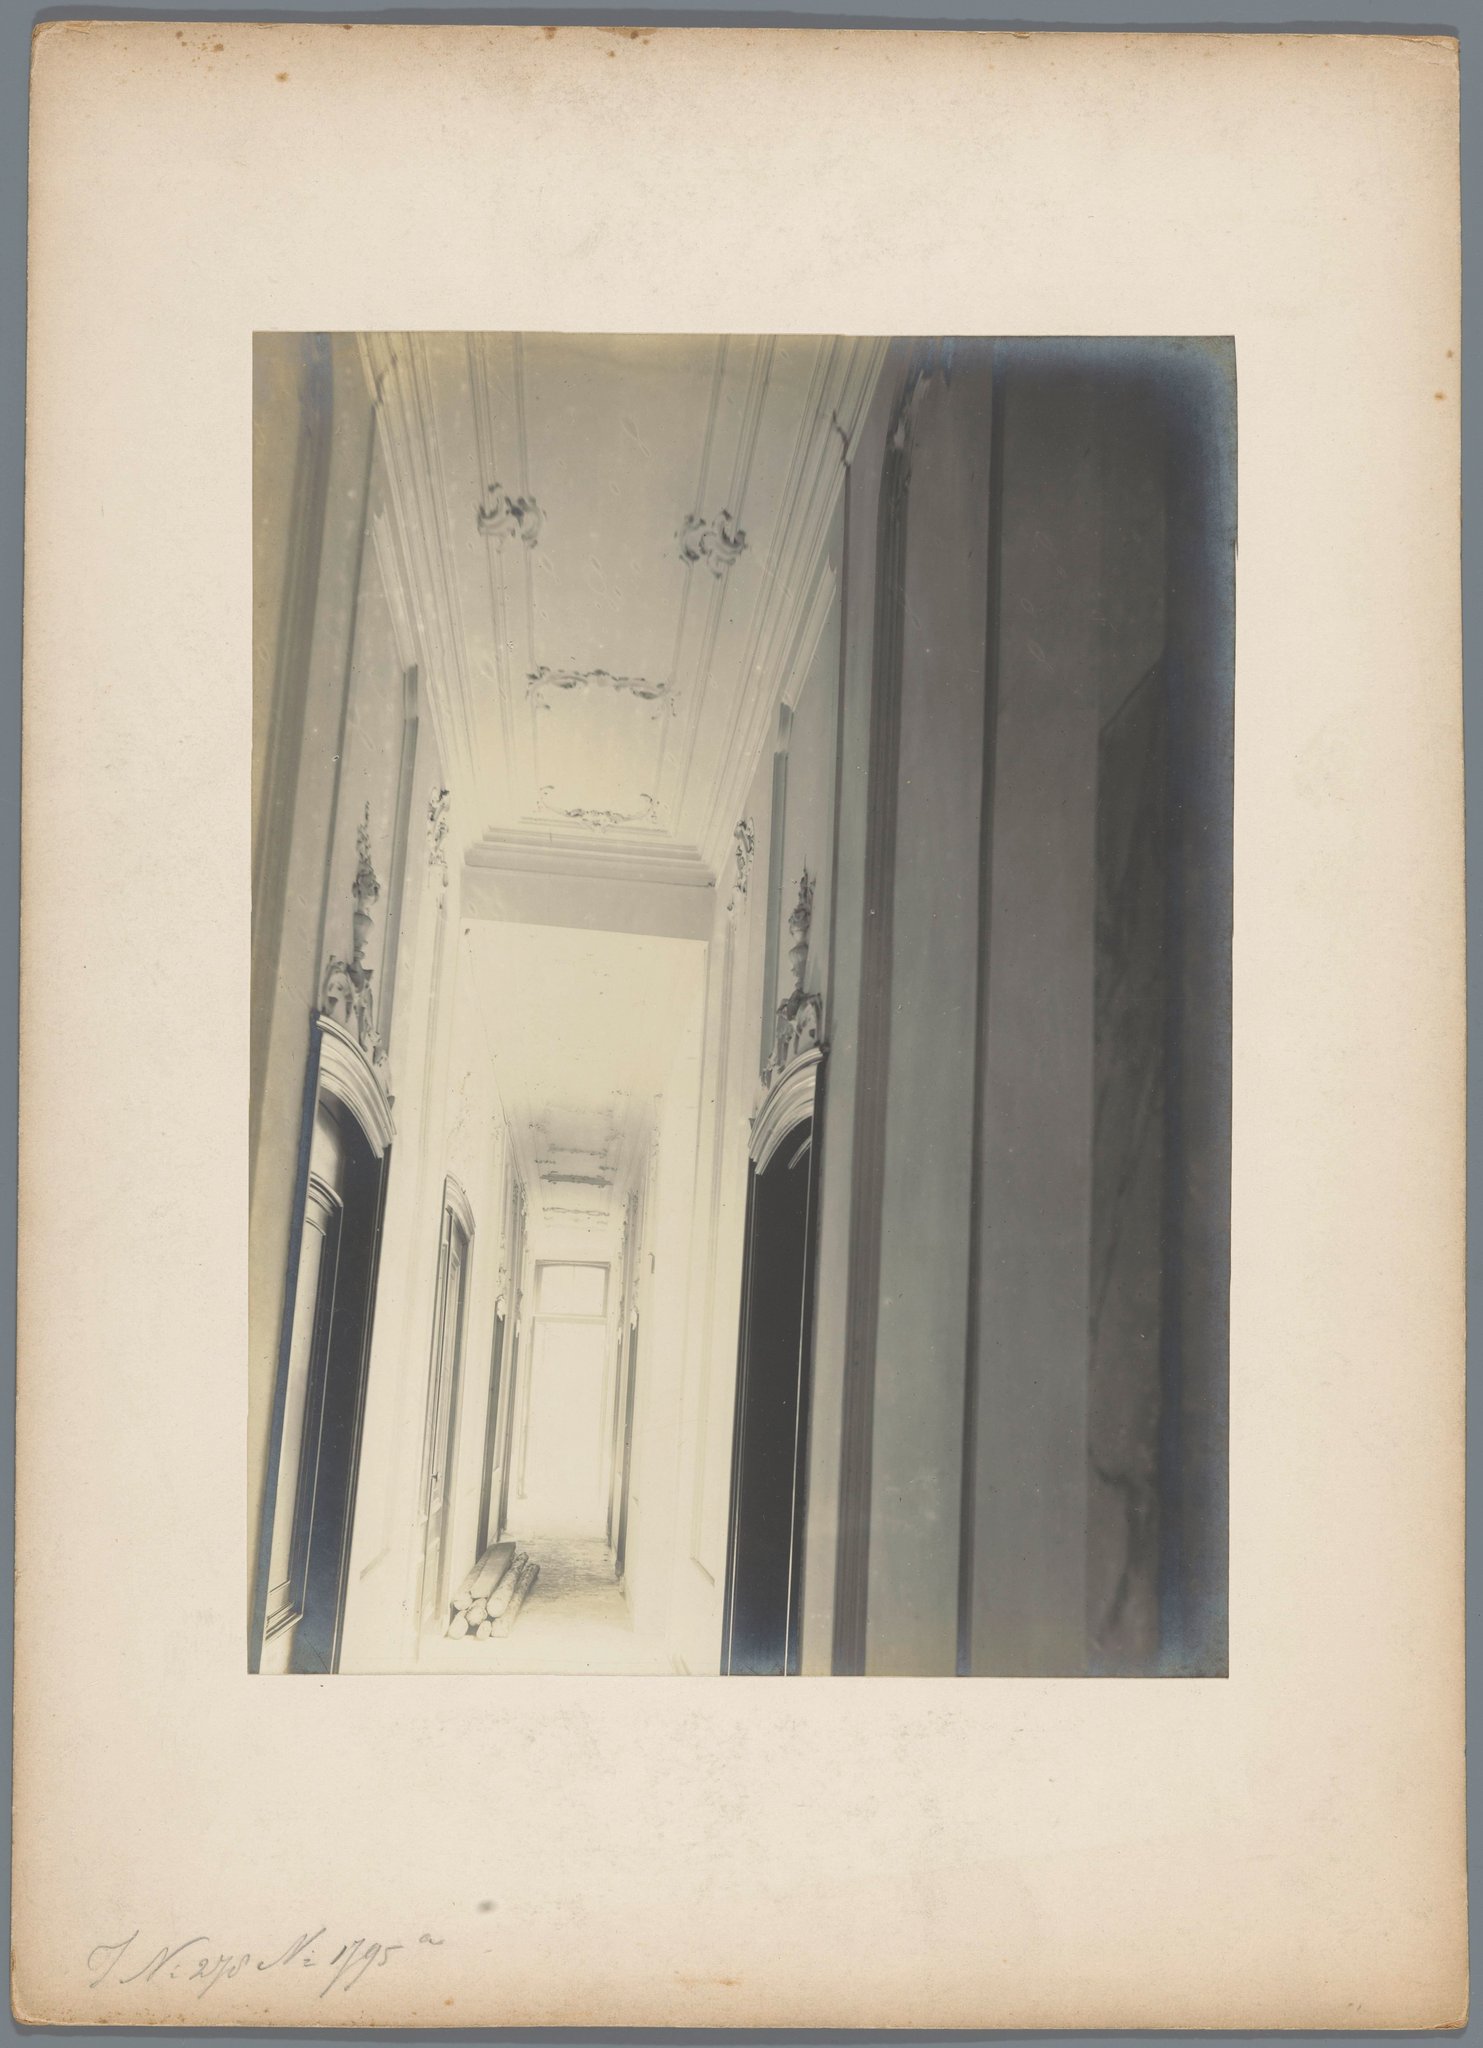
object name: photograph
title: Hal in het huis aan de Grote Houtstraat 39 te Haarlem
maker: Anonymous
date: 1900-1910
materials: cardboard, photographic support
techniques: gelatin silver print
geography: grote houtstraat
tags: corridor, open door, interior of the house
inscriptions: annotation, inscription: ‘Haarlem, N. H. Huis Groote Houtstr. 39 verbouwd Juli 1907.’, inscription: ‘neg. no 15253 foto 7482’